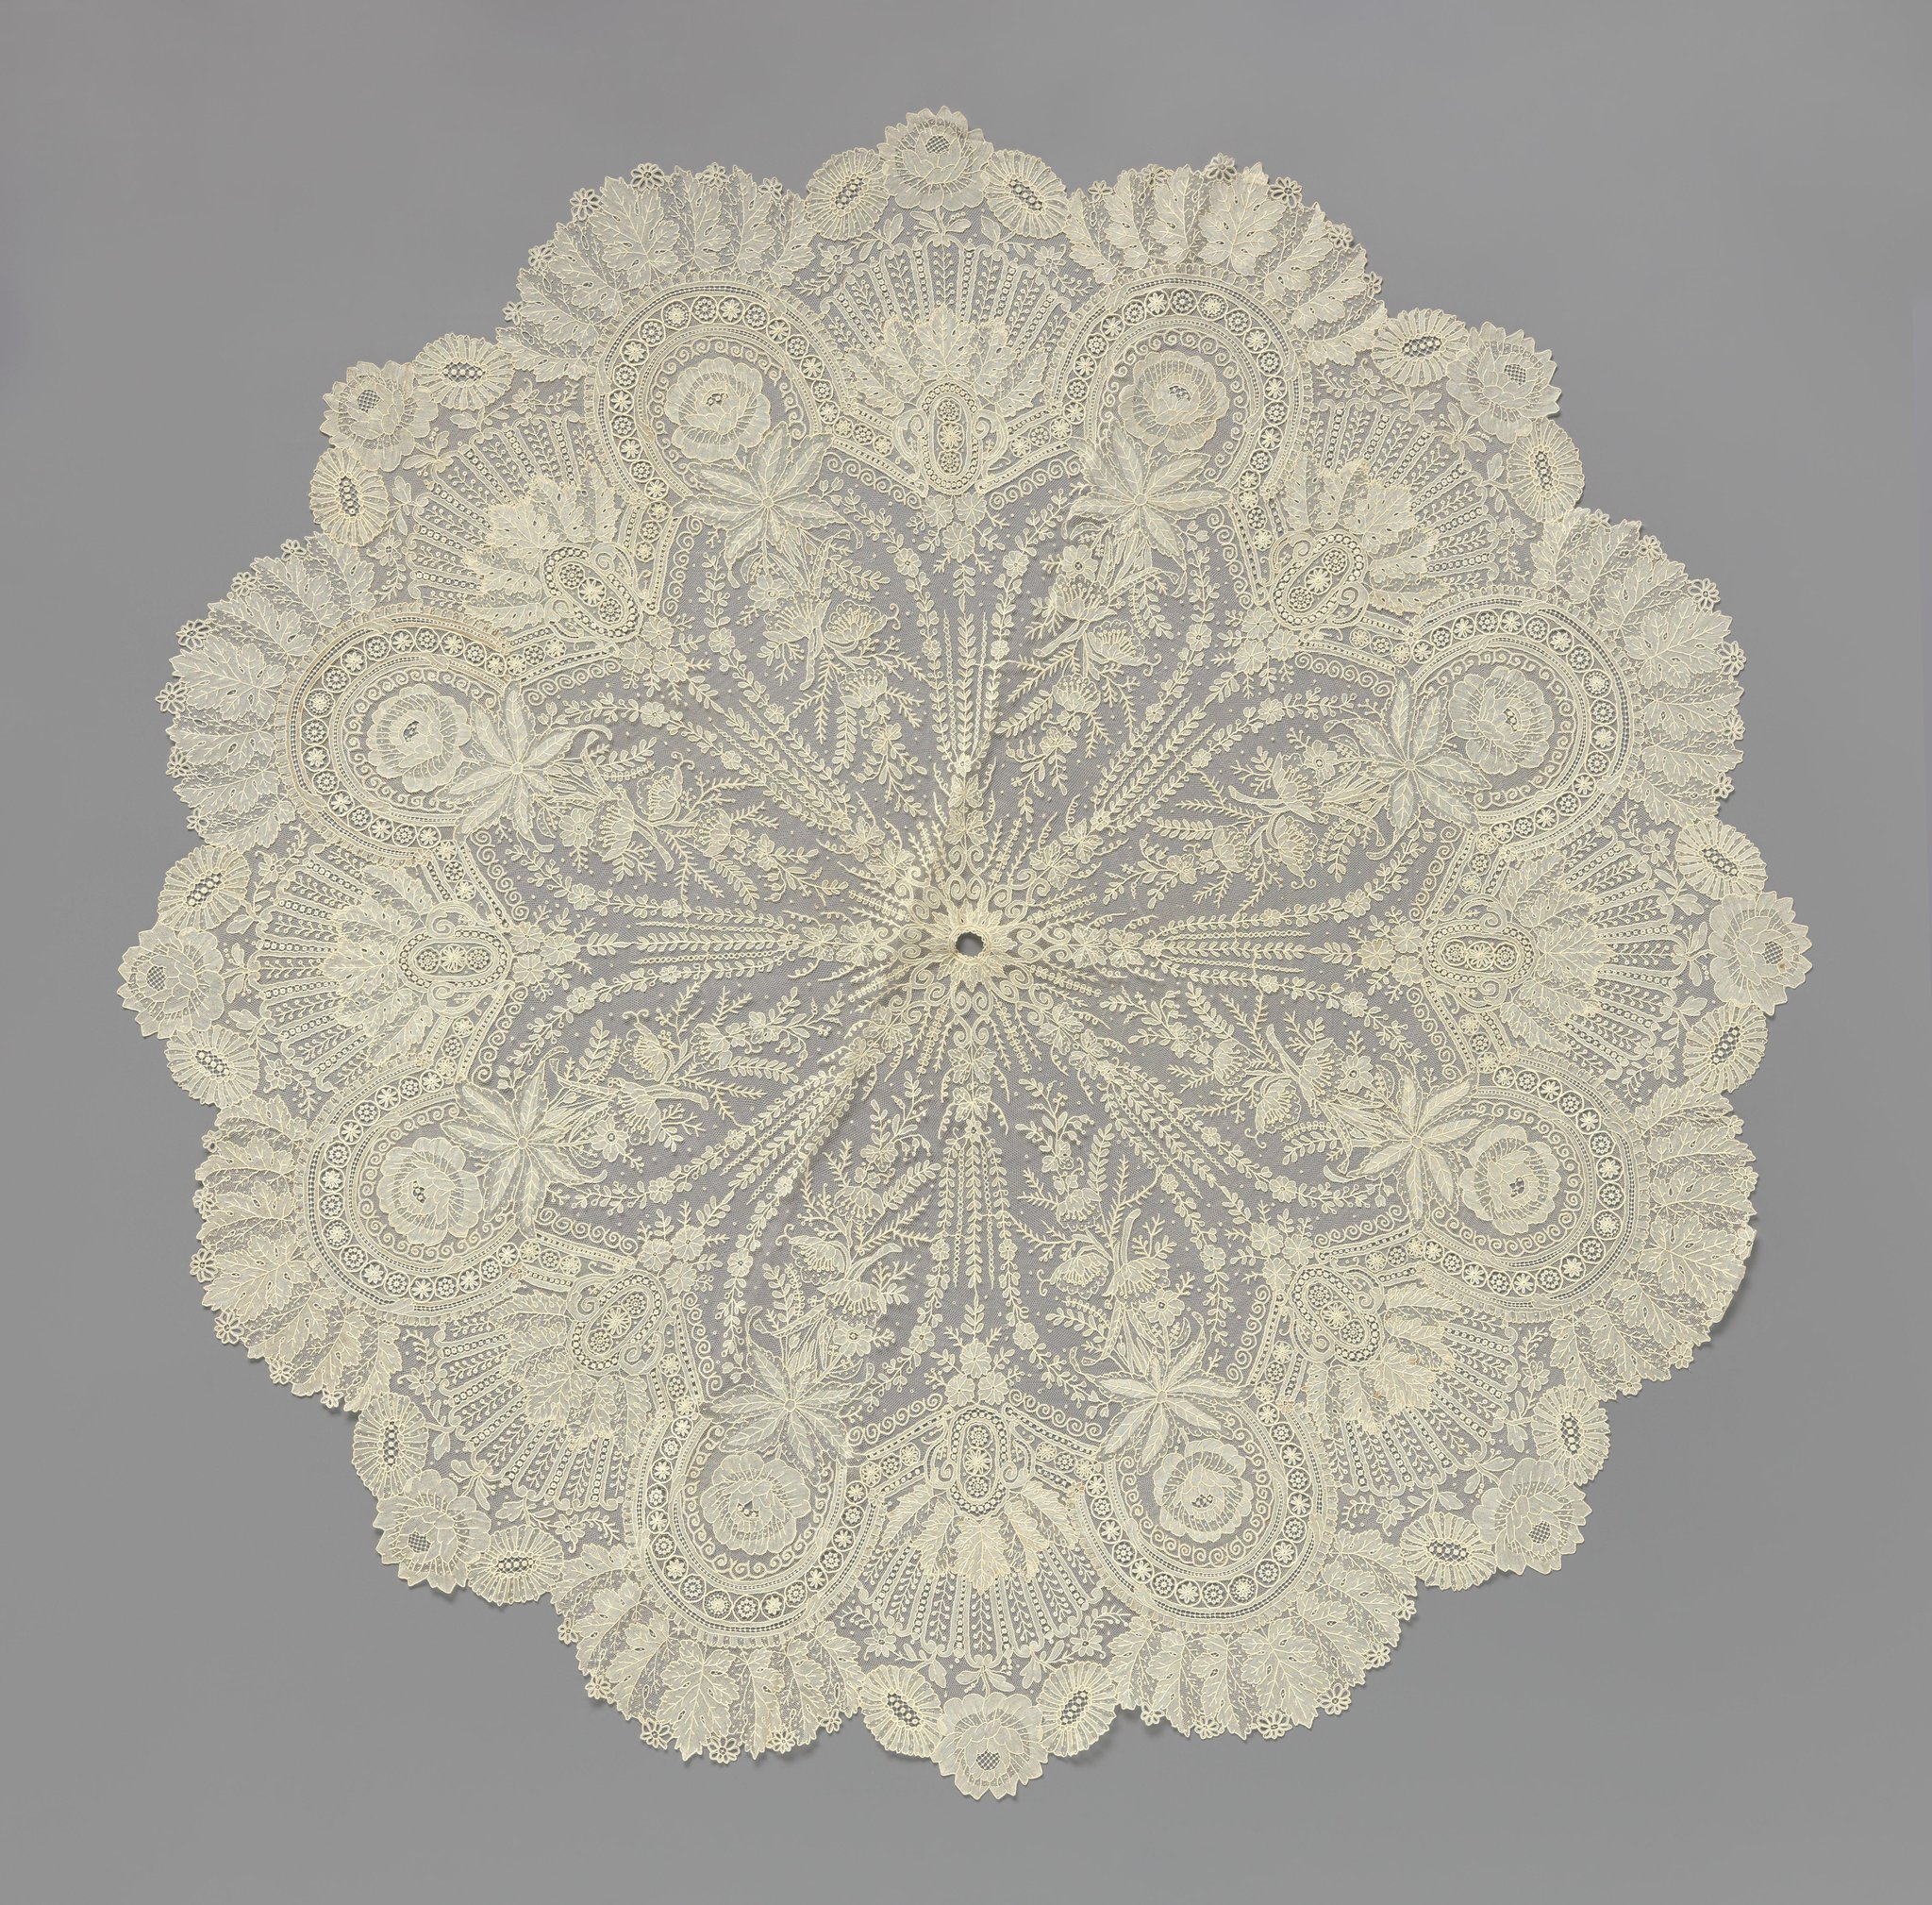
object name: parasoldek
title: Parasoldek van naaldkant met paraplublad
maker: Anonymous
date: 1880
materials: linen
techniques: needle lace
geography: brussels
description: Acht spitsovale velden worden begrensd door fijne bogen van treurwilgetakjes. Op deze velden staat telkens een boeket van drie knikkende bloempjes. Door een paraplublad worden de velden ingesnoerd en vervolgen in een hoefijzervormige schulp met een grote roos en met eikebladeren. Dit hoefijzer is gevormd door een vijfdubbele band, onder andere met cirkeltjes, die aan de binnenzijde van een tussenliggende schulp doorloopt. Deze kleinere schulp vertoont een waaier van eikebladeren en een waaier van godrons, met een rand van drie bloemen, namelijk een roos tussen twee margrieten. De eikebladeren zijn half in de schaduw gehouden. Point de gaze de Bruxelles.